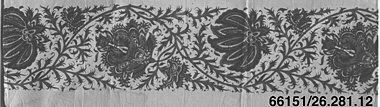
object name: sleeve band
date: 1867-1900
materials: cotton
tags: flowers,leaves